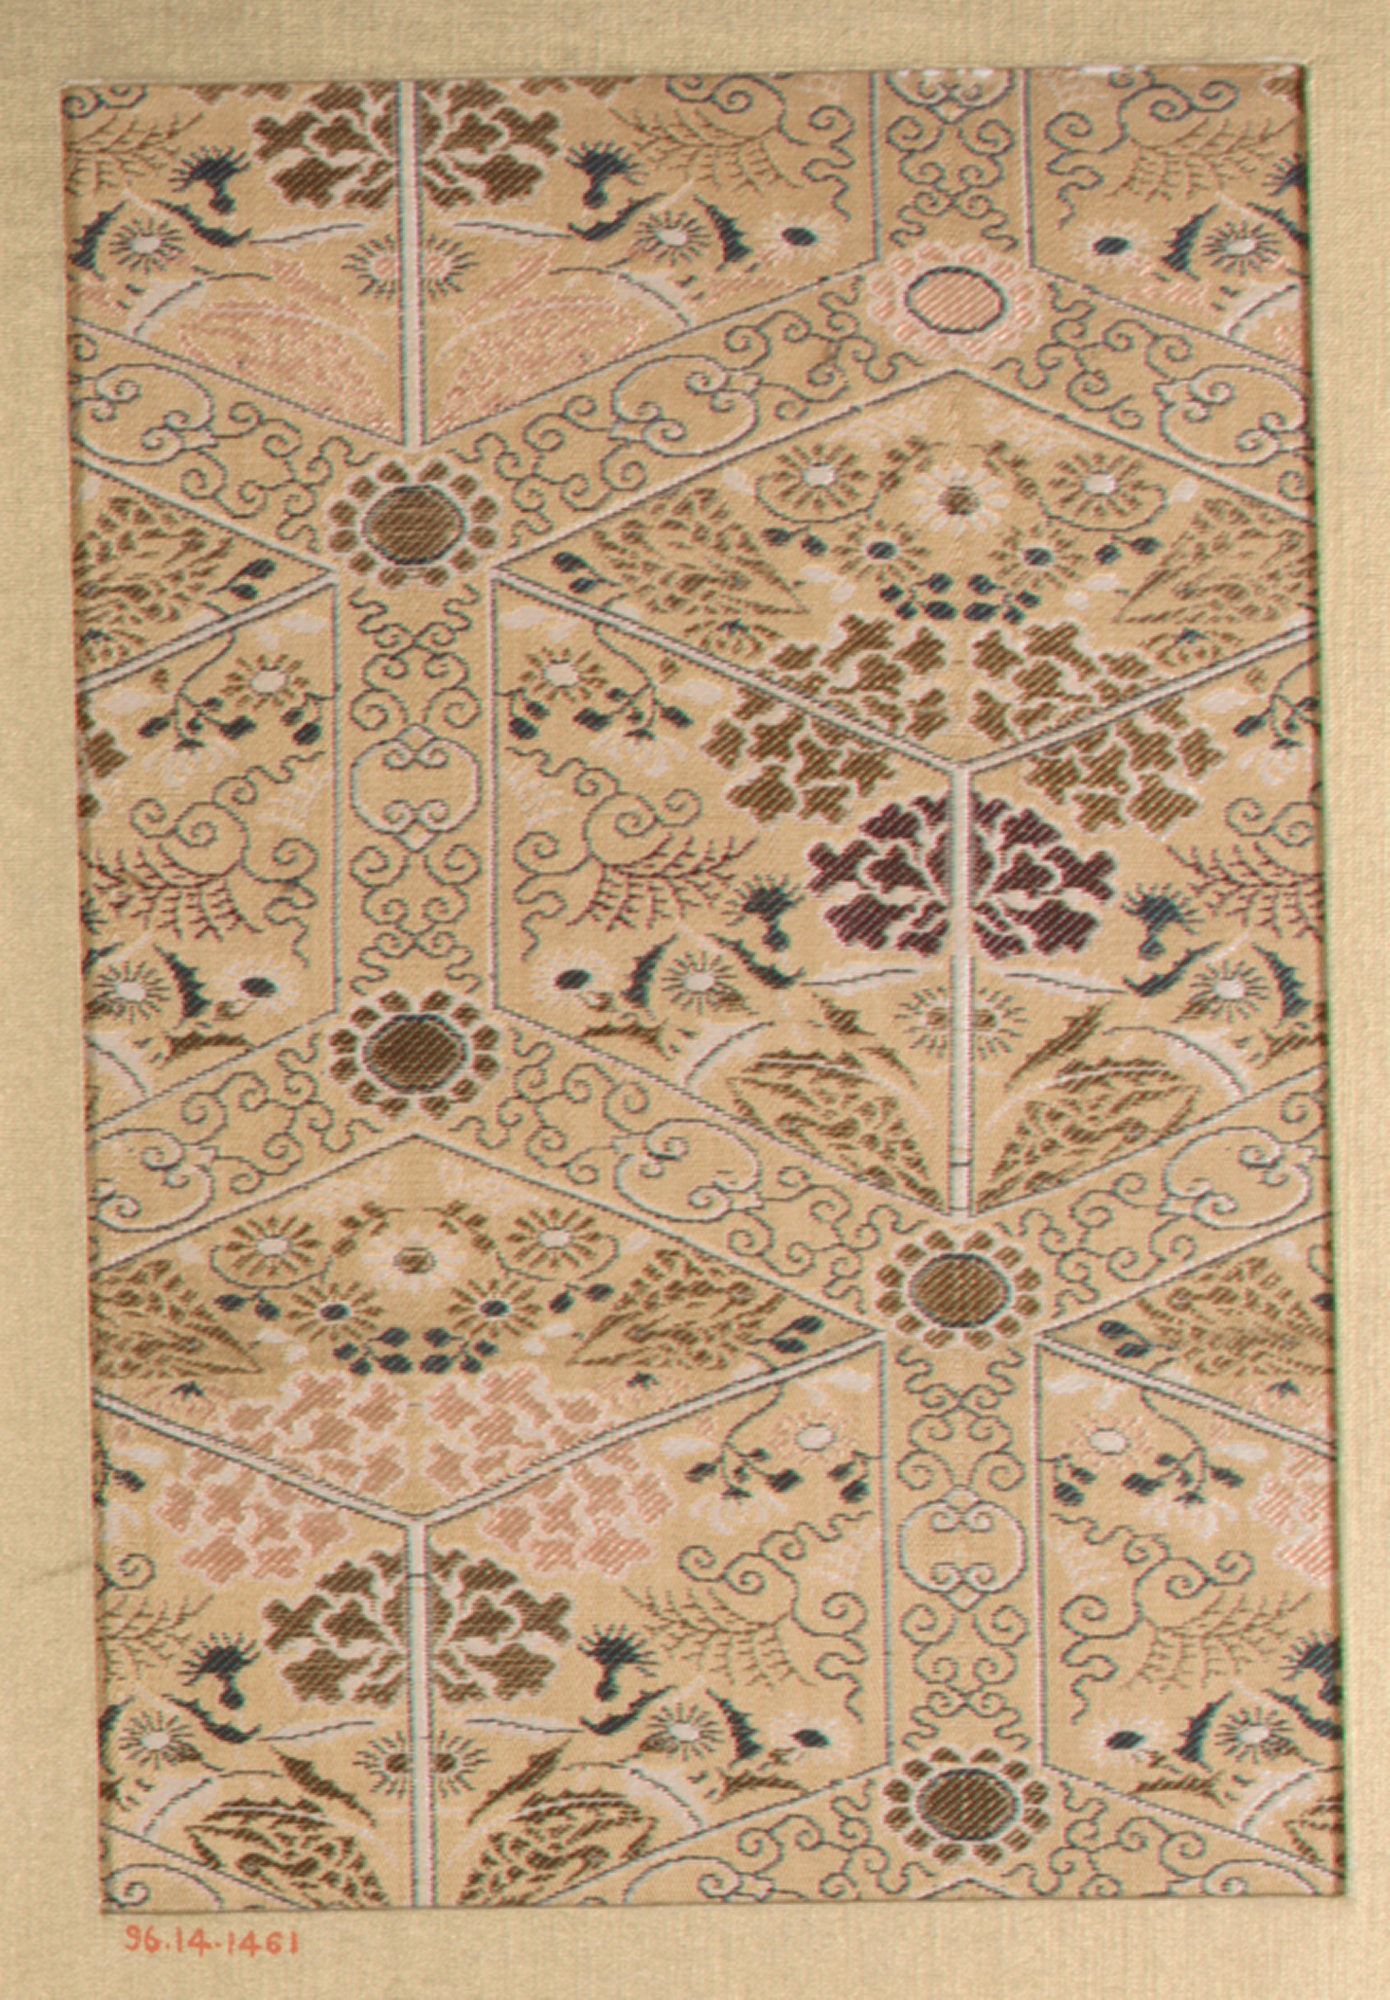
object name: piece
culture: japanese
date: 1701-1900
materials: silk